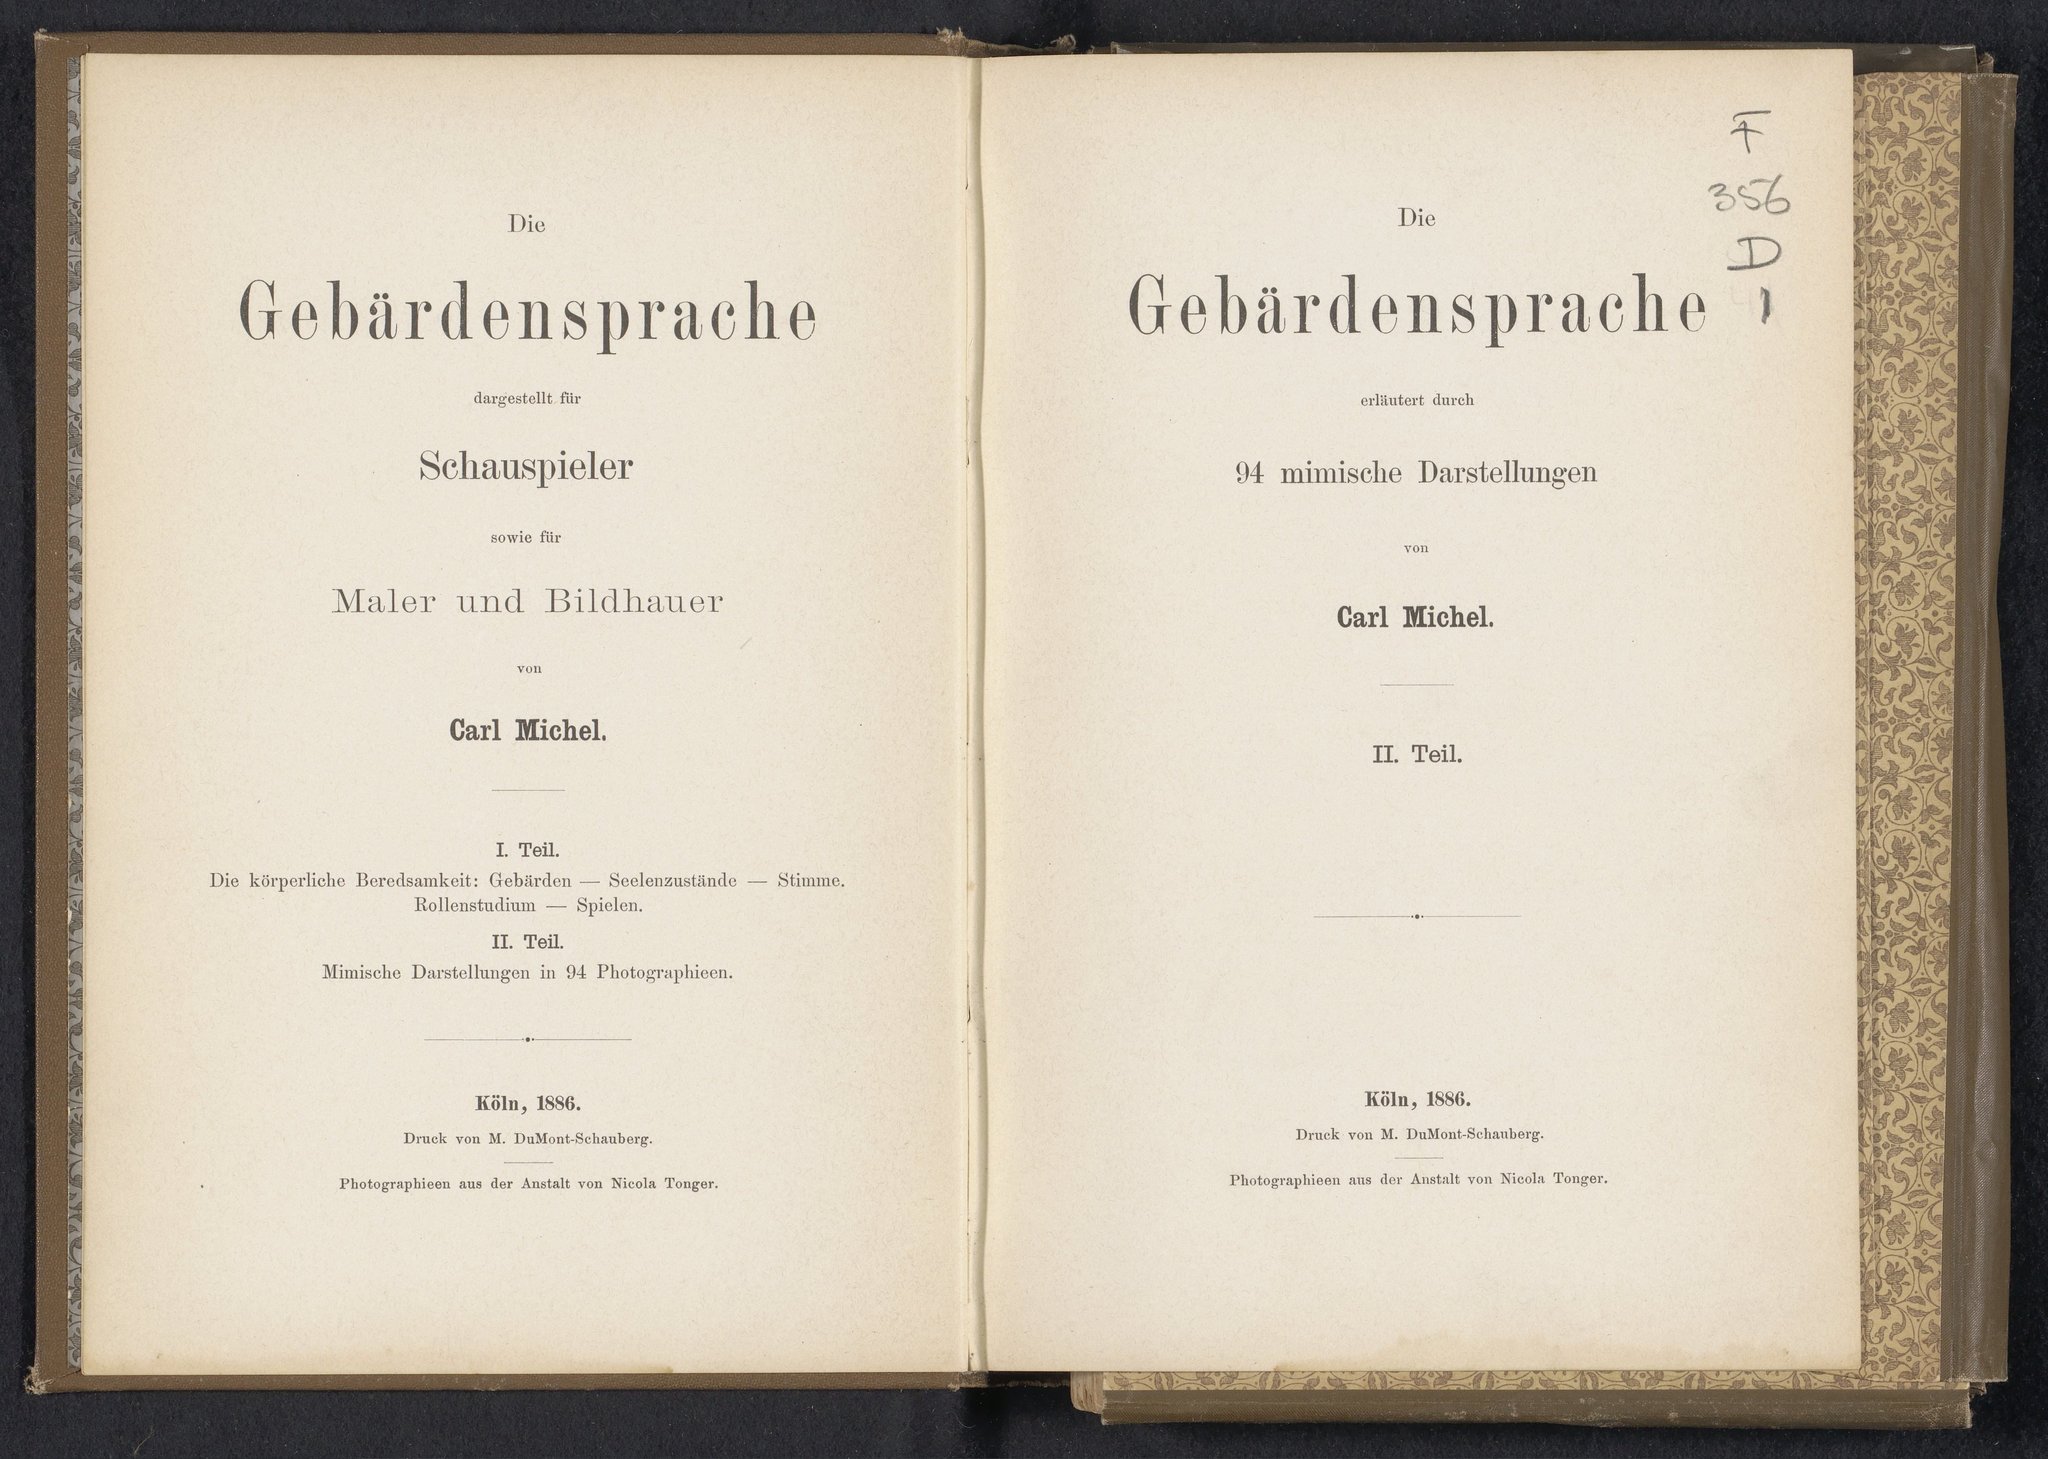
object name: page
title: Die Gebärdensprache dargestellt für Schauspieler sowie für Maler und Bildhauer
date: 1886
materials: cardboard, linen, paper, photographic support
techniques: albumen print, printing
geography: cologne